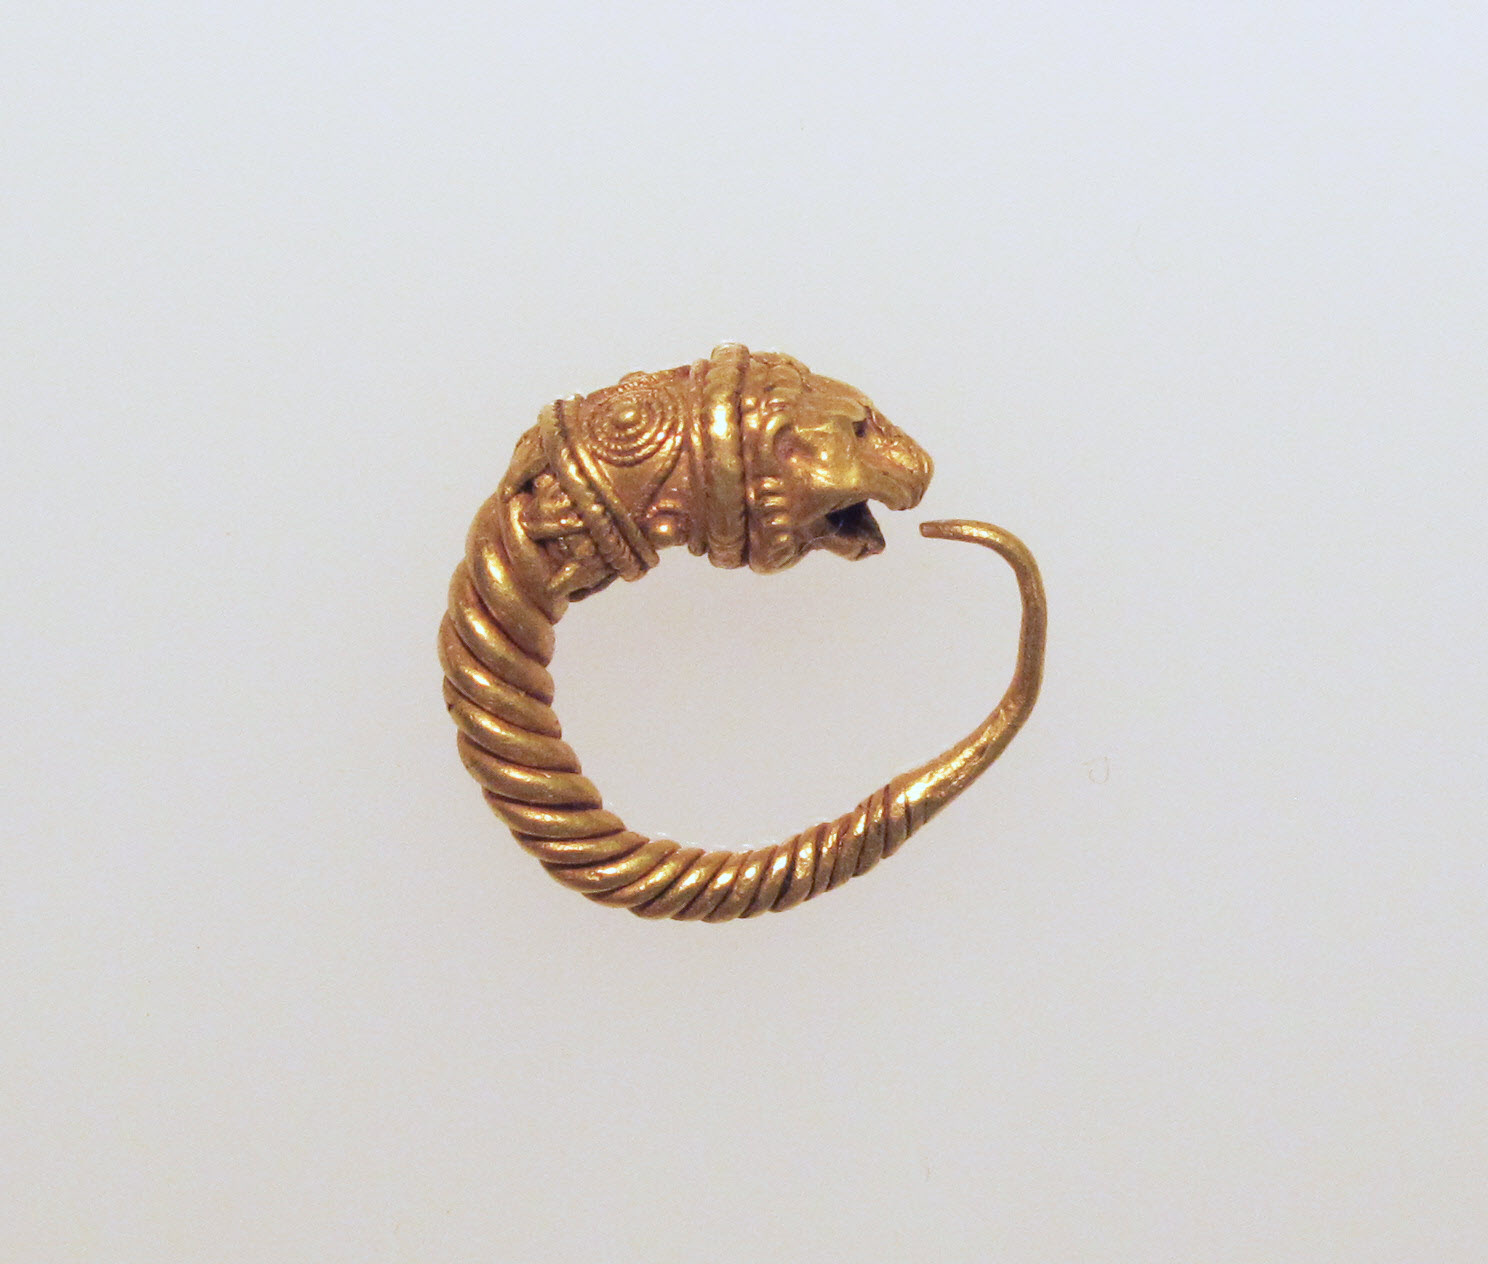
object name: earring with head of lion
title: Gold earring with head of a lion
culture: greek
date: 400-201 BCE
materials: gold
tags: lions